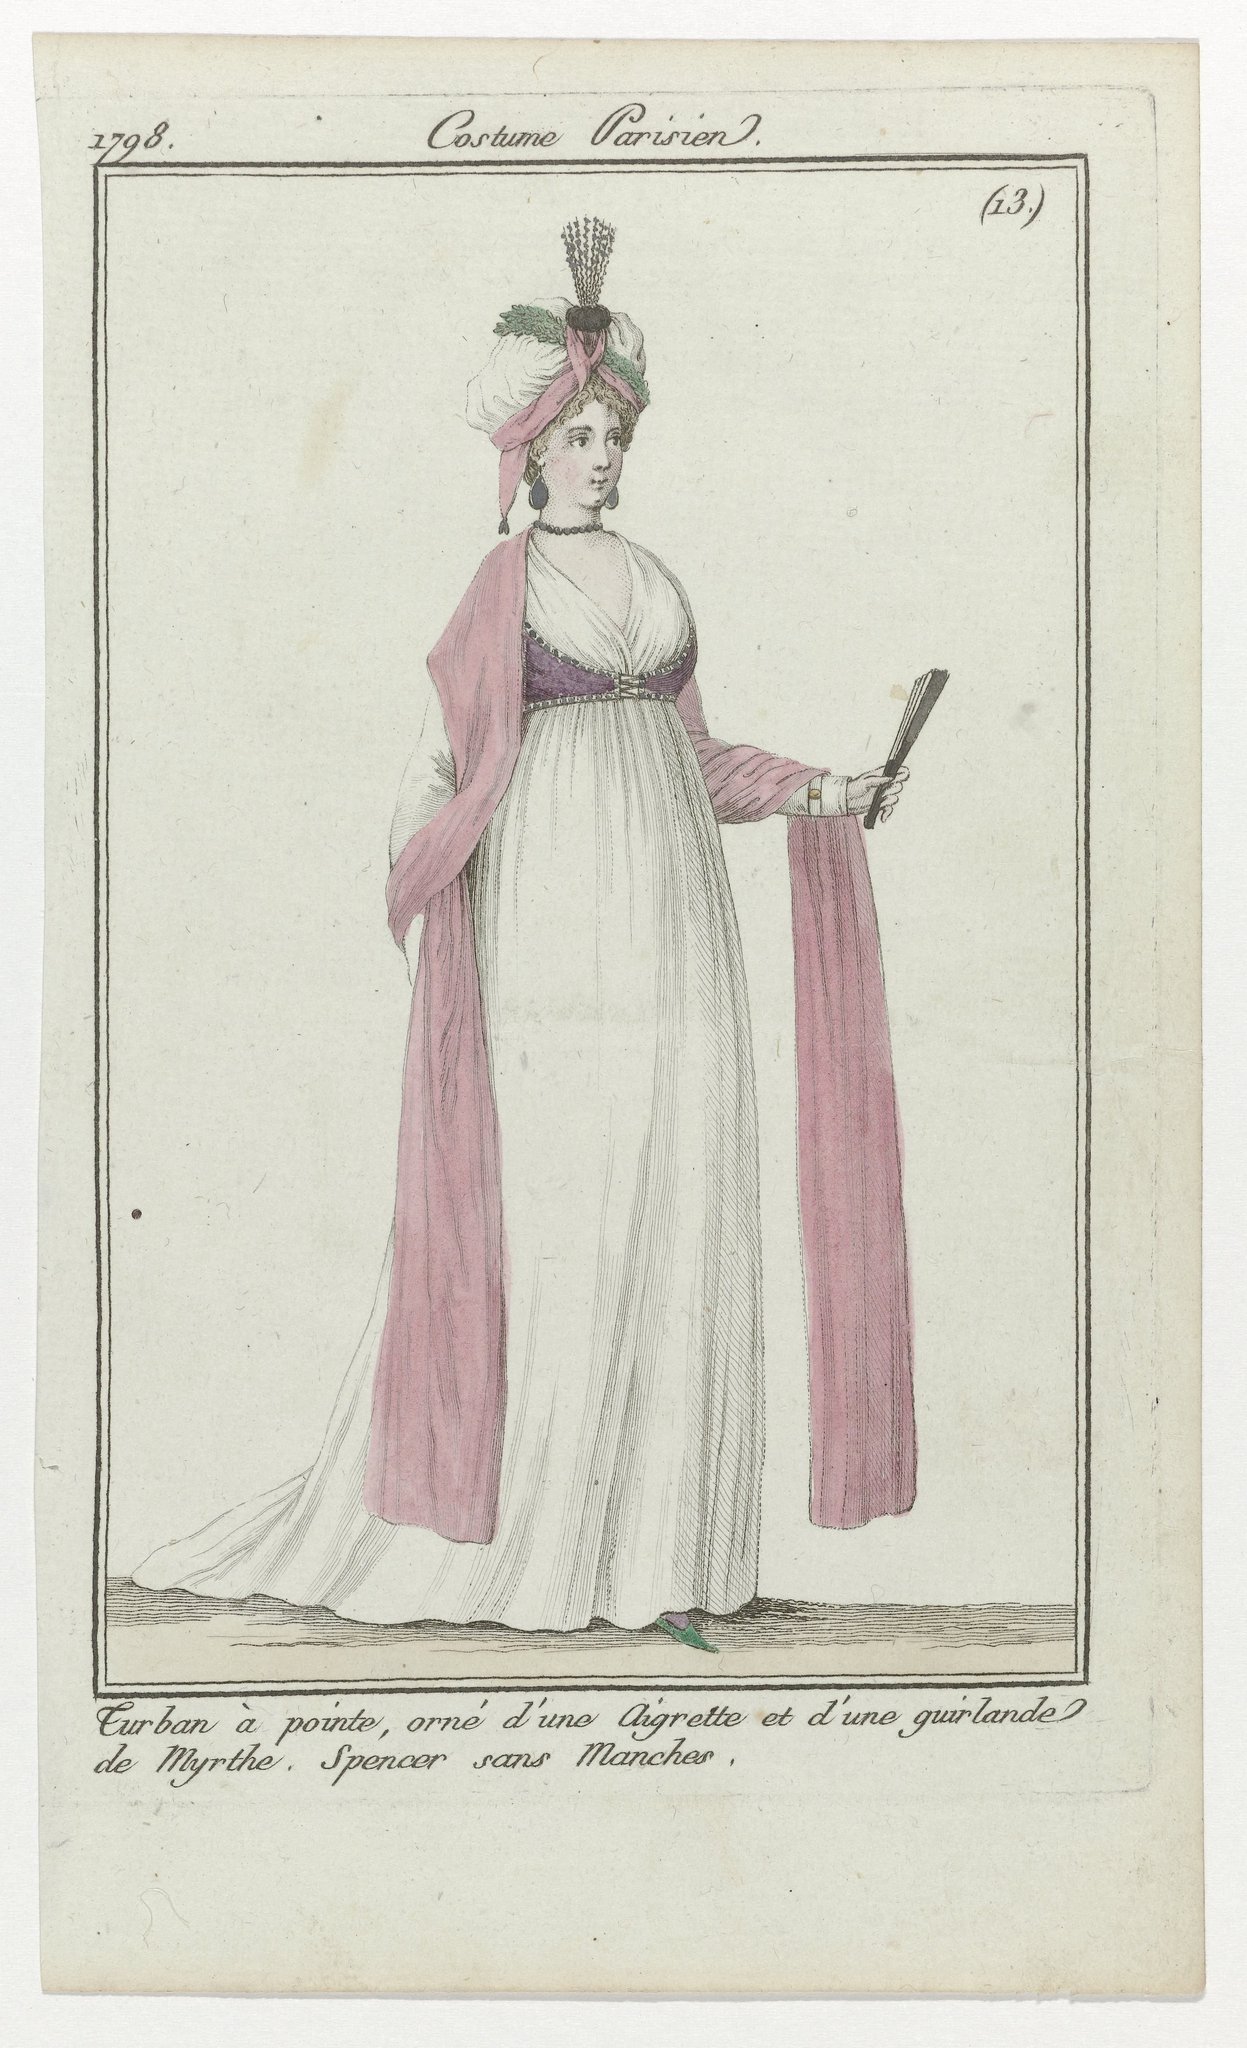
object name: fashion print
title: Journal des Dames et des Modes, Costume Parisien, 1 avril 1798, (13) : Turban à point (...)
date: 1798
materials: paper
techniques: engraving, hand coloring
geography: paris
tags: ear-rings (+ women's clothes), head-gear: turban (+ women's clothes), clothing for the upper part of the body (shawl) (+ women's clothes), clothing for the upper part of the body (spencer) (+ women's clothes), fashion plates, shoes, sandals (+ women's clothes), dress, gown (+ women's clothes), fan (+ women's clothes), necklace (+ women's clothes)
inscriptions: title: ‘Costume Parisien.’, caption: ‘Turban à pointe, orné Aigrette et d'une guirlande de Myrthe. Spencer sans Manches.’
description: Tulband met slip, versierd met een aigrette en een guirlande van mirte. Spencer zonder mouwen op een japon met lange mouwen en sleep. Accessoires: oorbellen, collier, lange sjaal om de schouders, armband(?), waaier, schoen met puntige neus. De prent maakt deel uit van het modetijdschrift Journal des Dames et des Modes, uitgegeven door Sellèque, Parijs, 1797-1839.